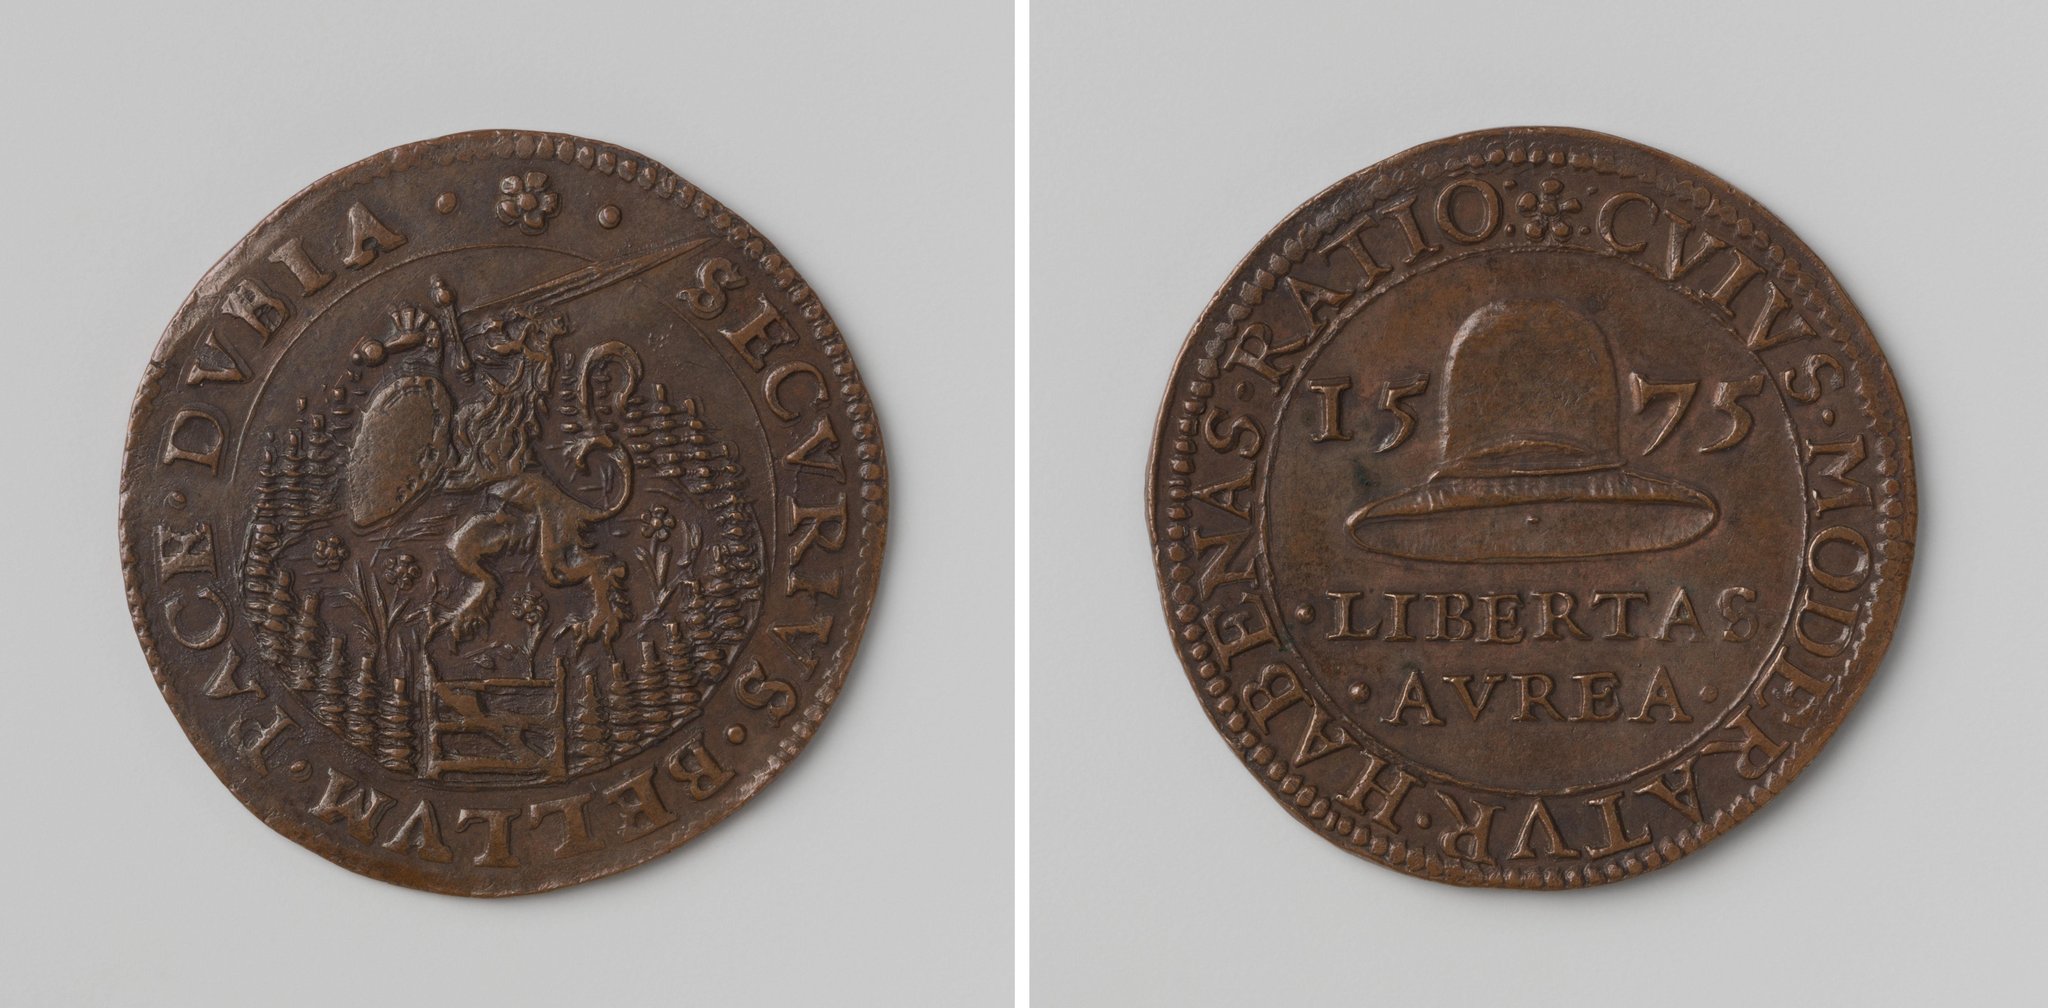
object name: jeton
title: Mislukte vredesonderhandelingen te Breda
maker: Anonymous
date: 1575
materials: copper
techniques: striking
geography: dordrecht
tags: breda, tachtigjarige oorlog, vredesonderhandelingen te breda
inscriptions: circumscription: ‘CVIVS MODERATVR HABENAS RATIO / 1575 / LIBERTAS AVREA’, circumscription: ‘SECVRIVS BELLVM PACE DVBIA’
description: Koperen penning. Voorzijde: Nederlandse leeuw met zwaard en schild temidden van bloemen in omheinde tuin binnen omschrift. Keerzijde: vrijheidshoed tussen jaartal boven opschrift binnen omschrift